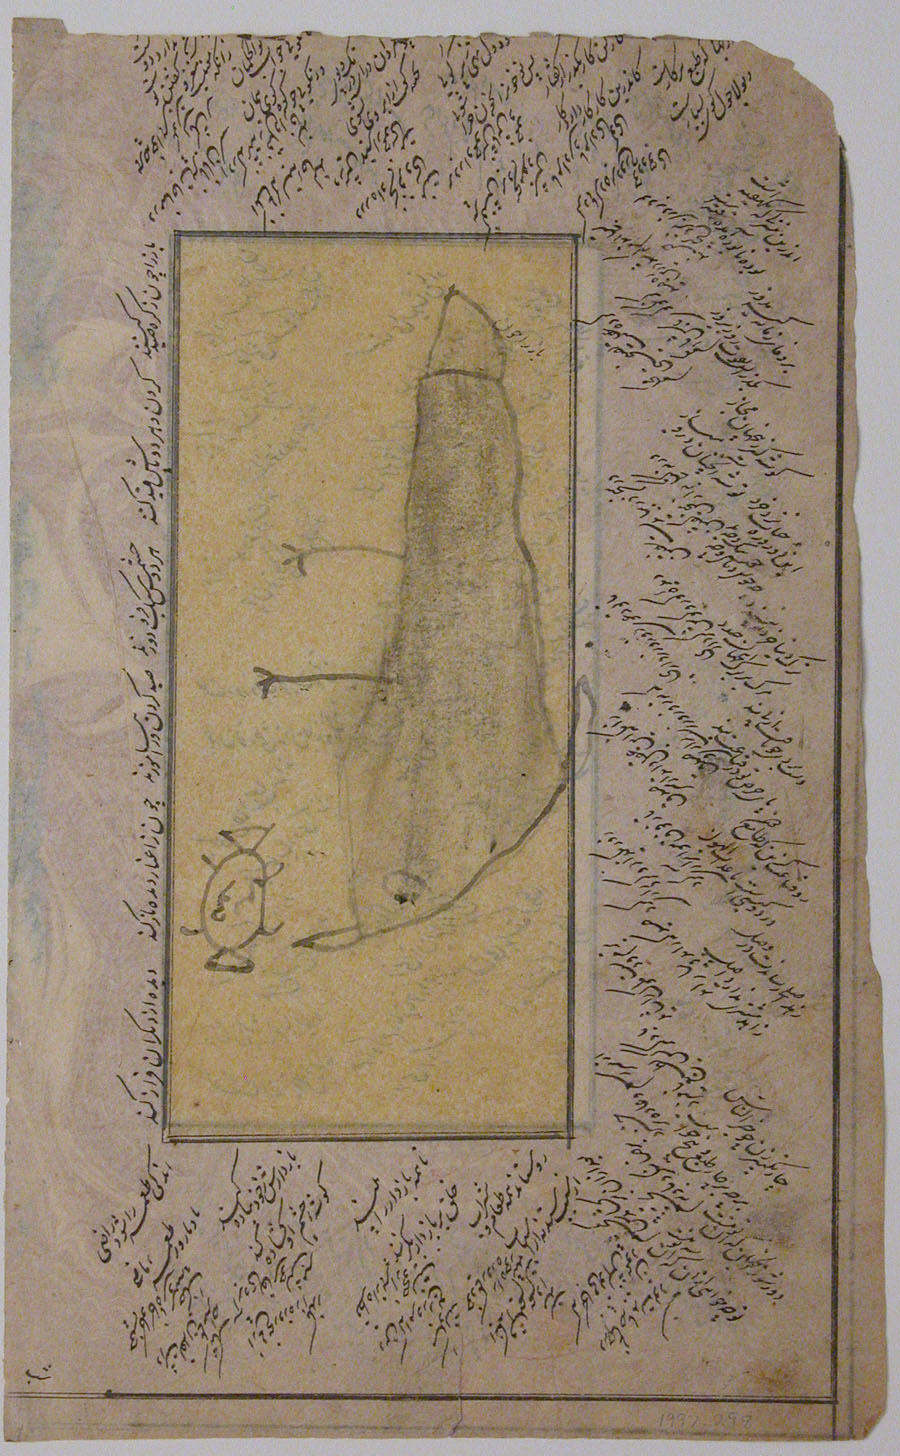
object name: non illustrated single work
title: Page of Calligraphy with Scribbled Bird and Insect?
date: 1501-1700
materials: ink, paper, watercolor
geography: iran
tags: birds,insects,calligraphy